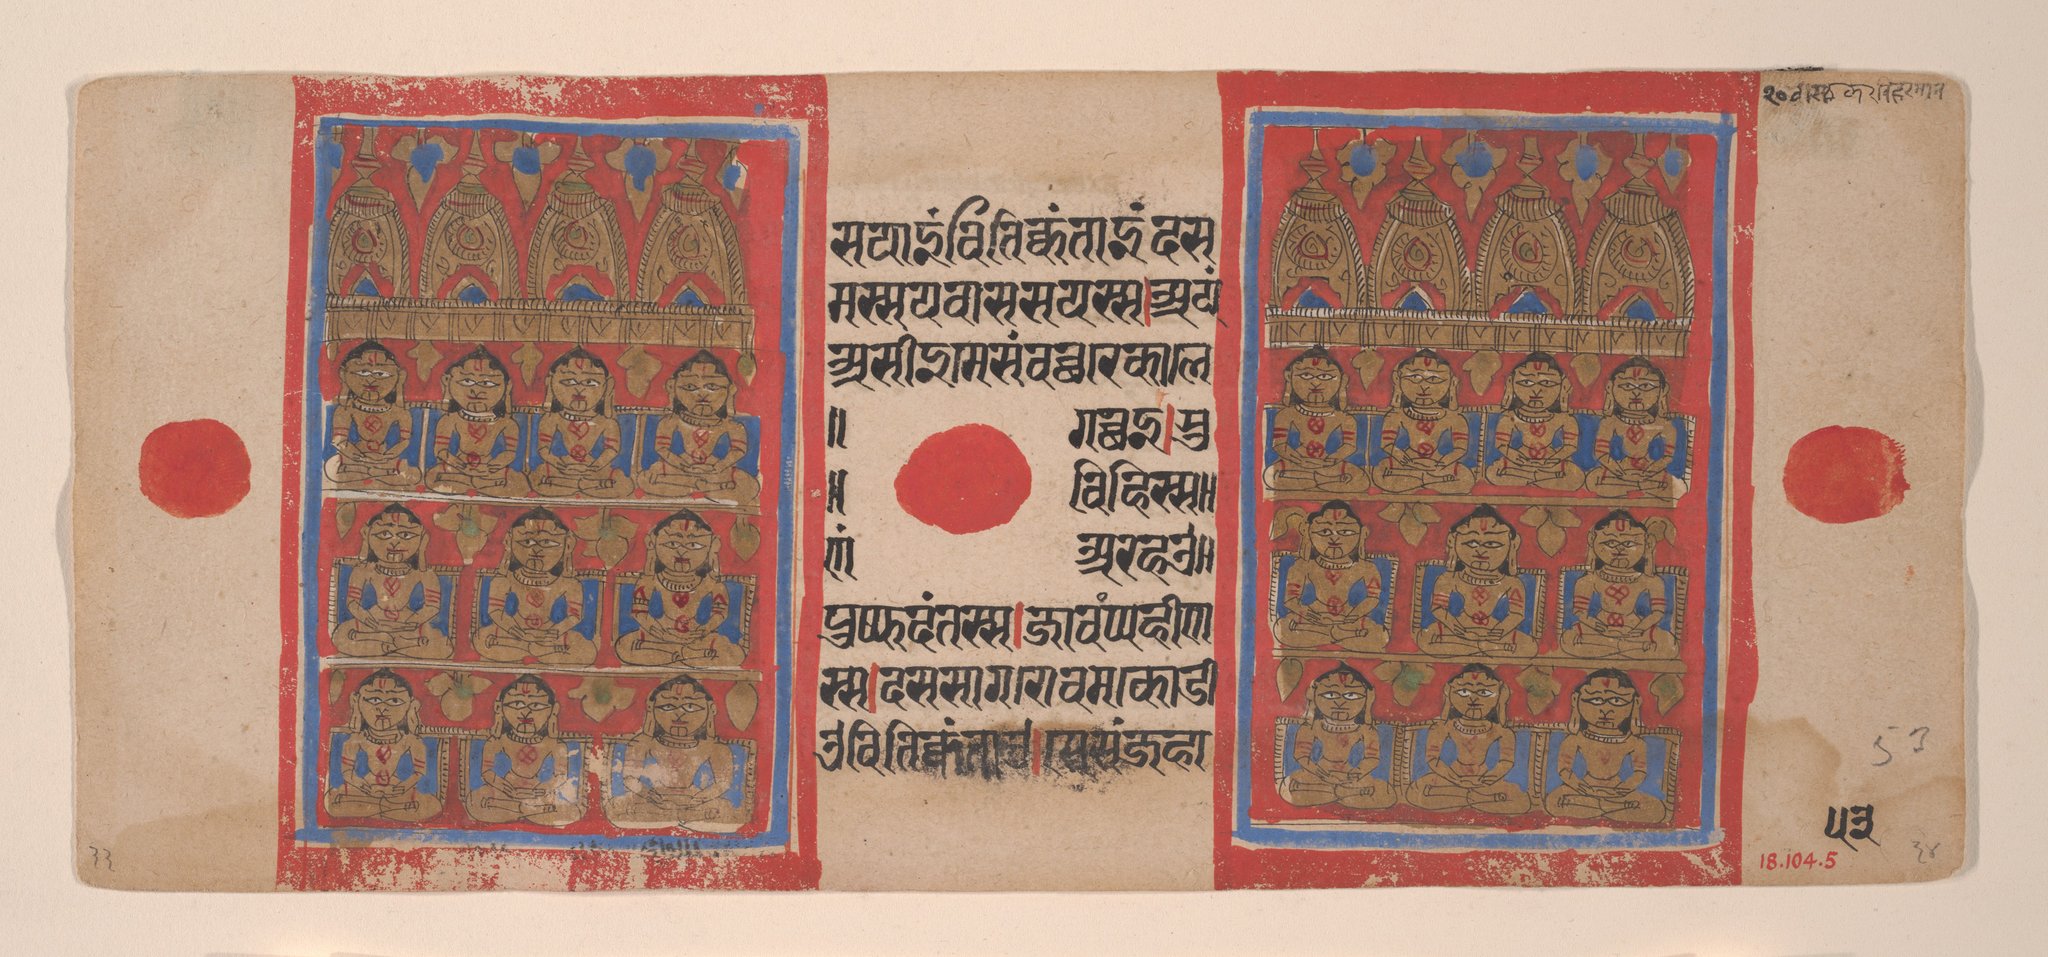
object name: manuscript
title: The Twenty Tirthankaras: Folio from a Kalpasutra Manuscript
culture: indian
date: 1461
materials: gold, ink, paper, watercolor